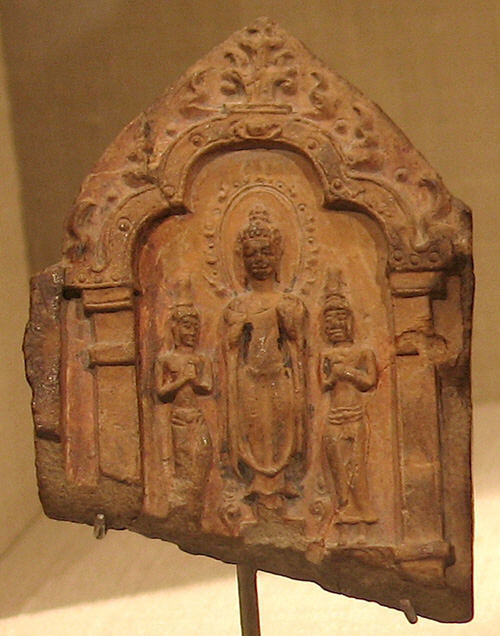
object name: votive plaque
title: Standing Buddha and Two Bodhisattvas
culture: thai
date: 601-900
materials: terracotta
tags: buddhism,bodhisattvas,buddha